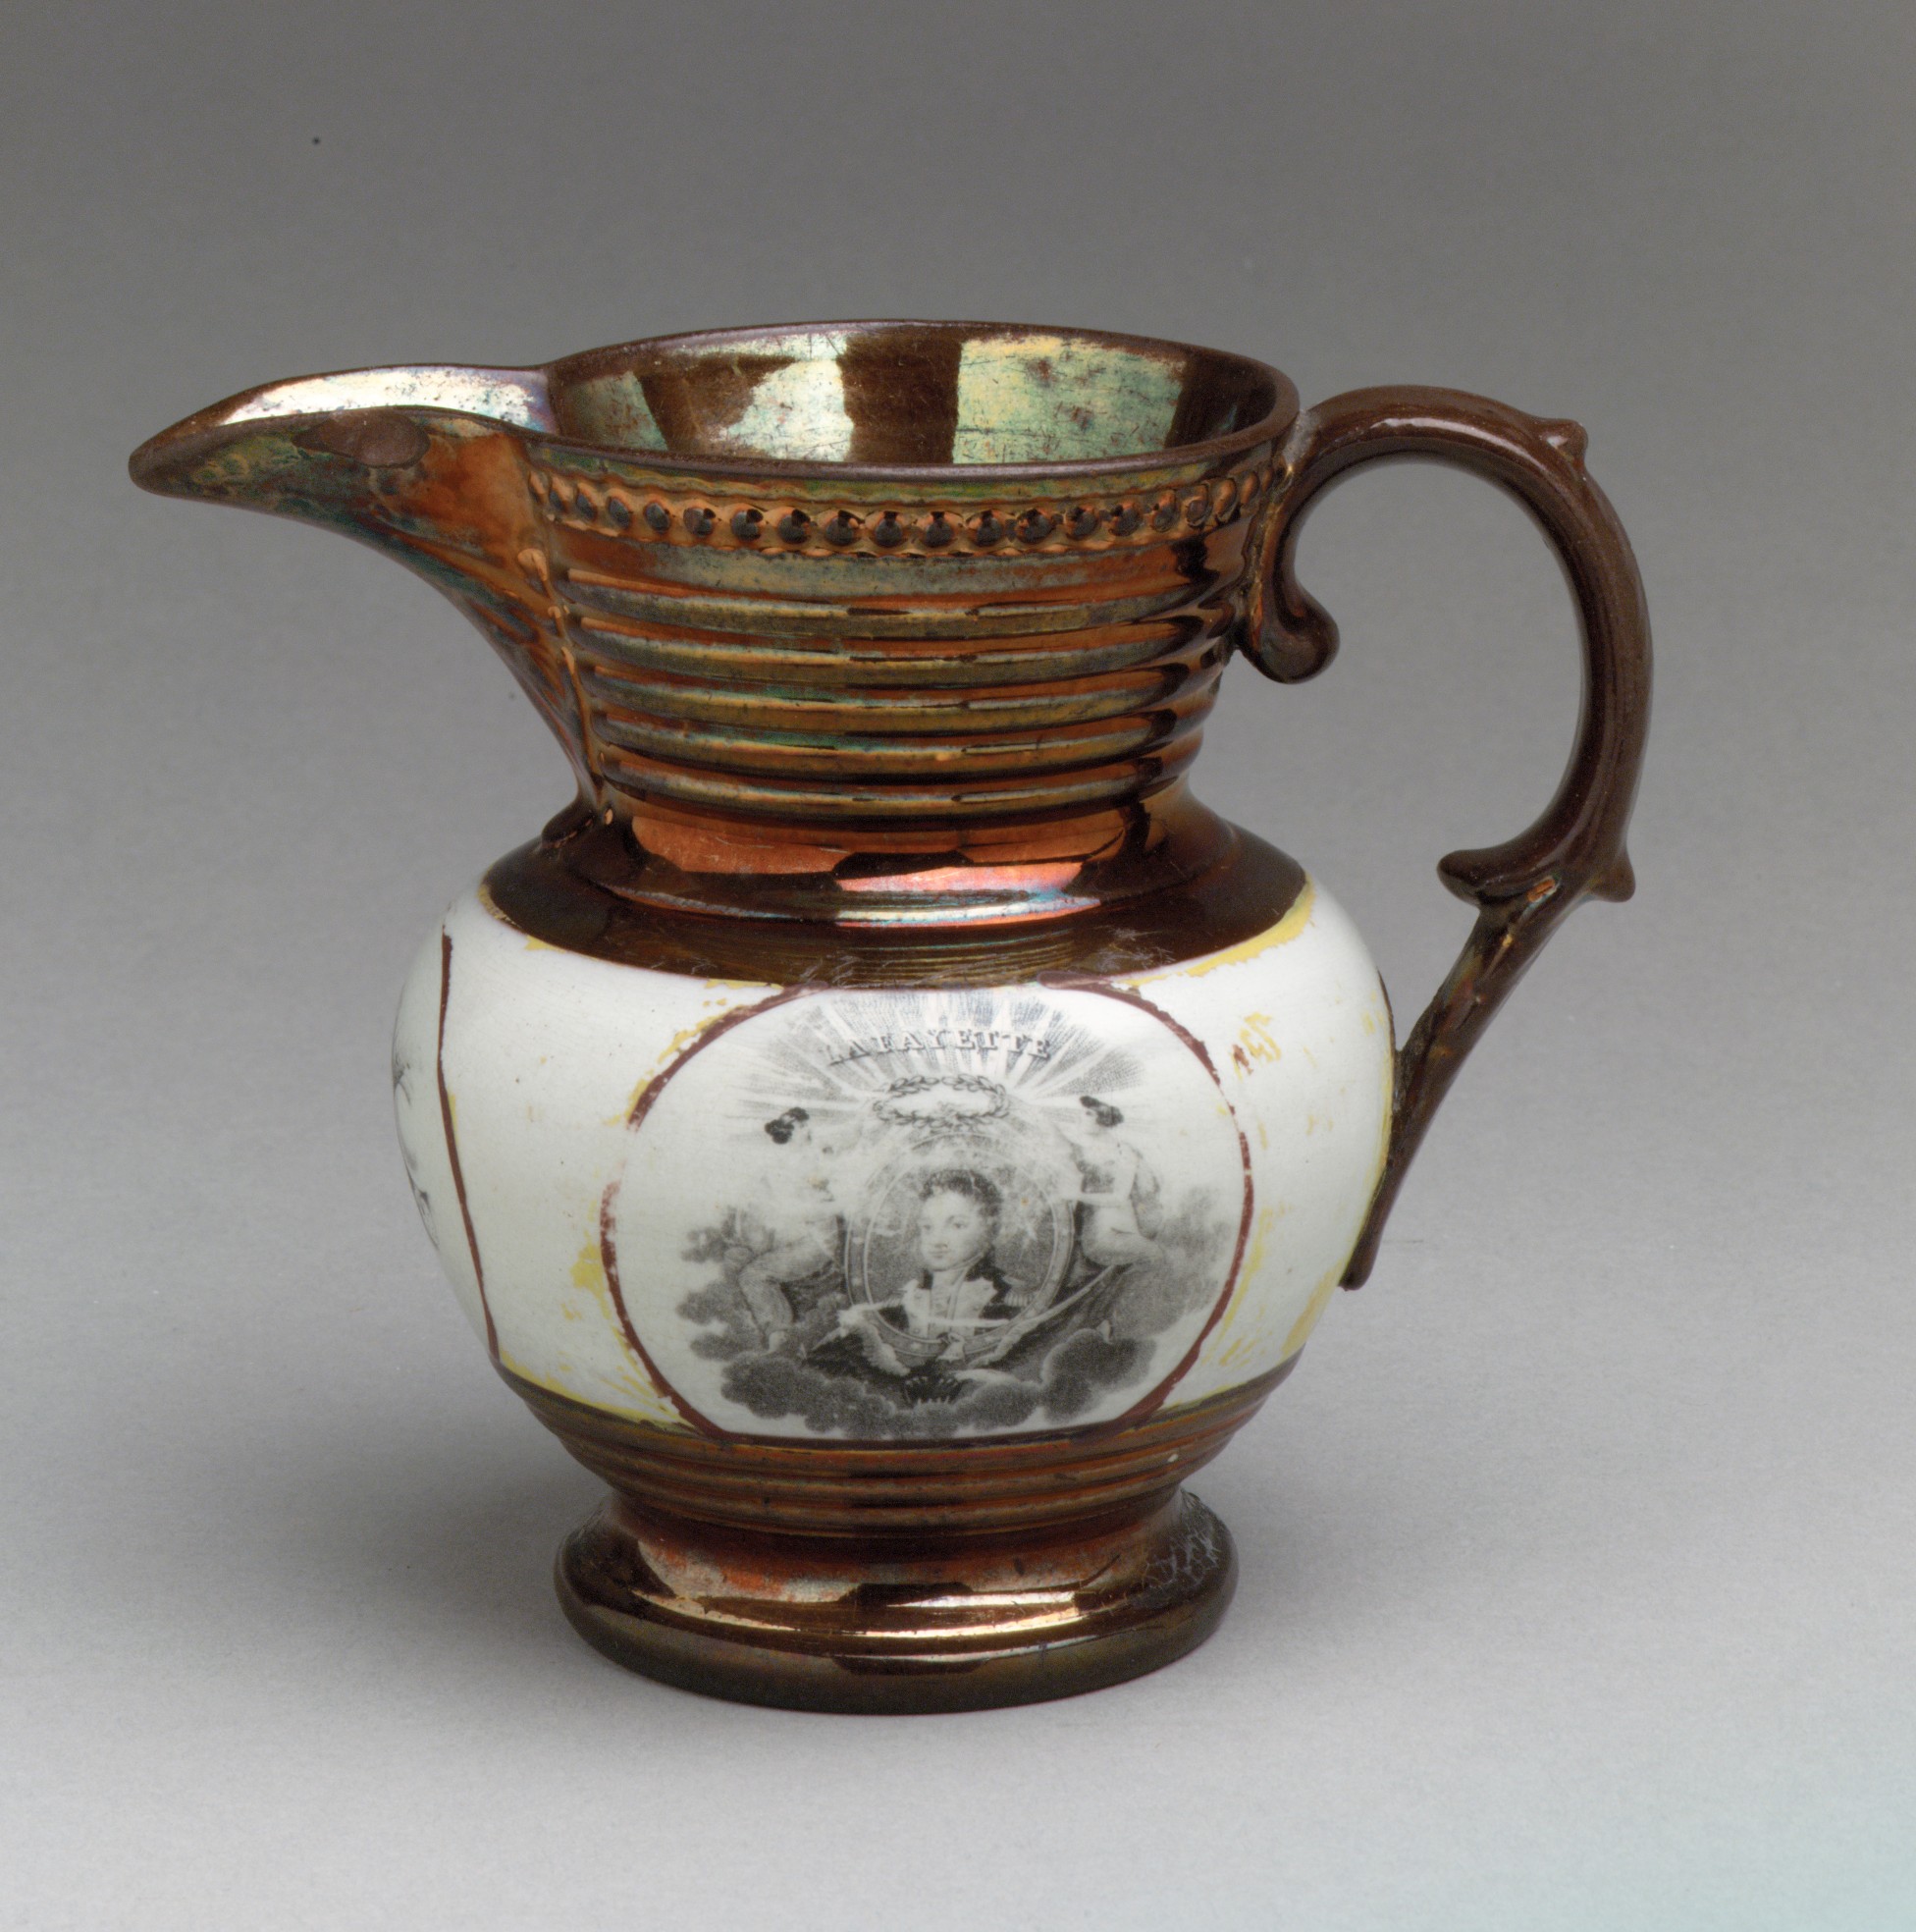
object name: pitcher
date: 1801-1900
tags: boys,portraits